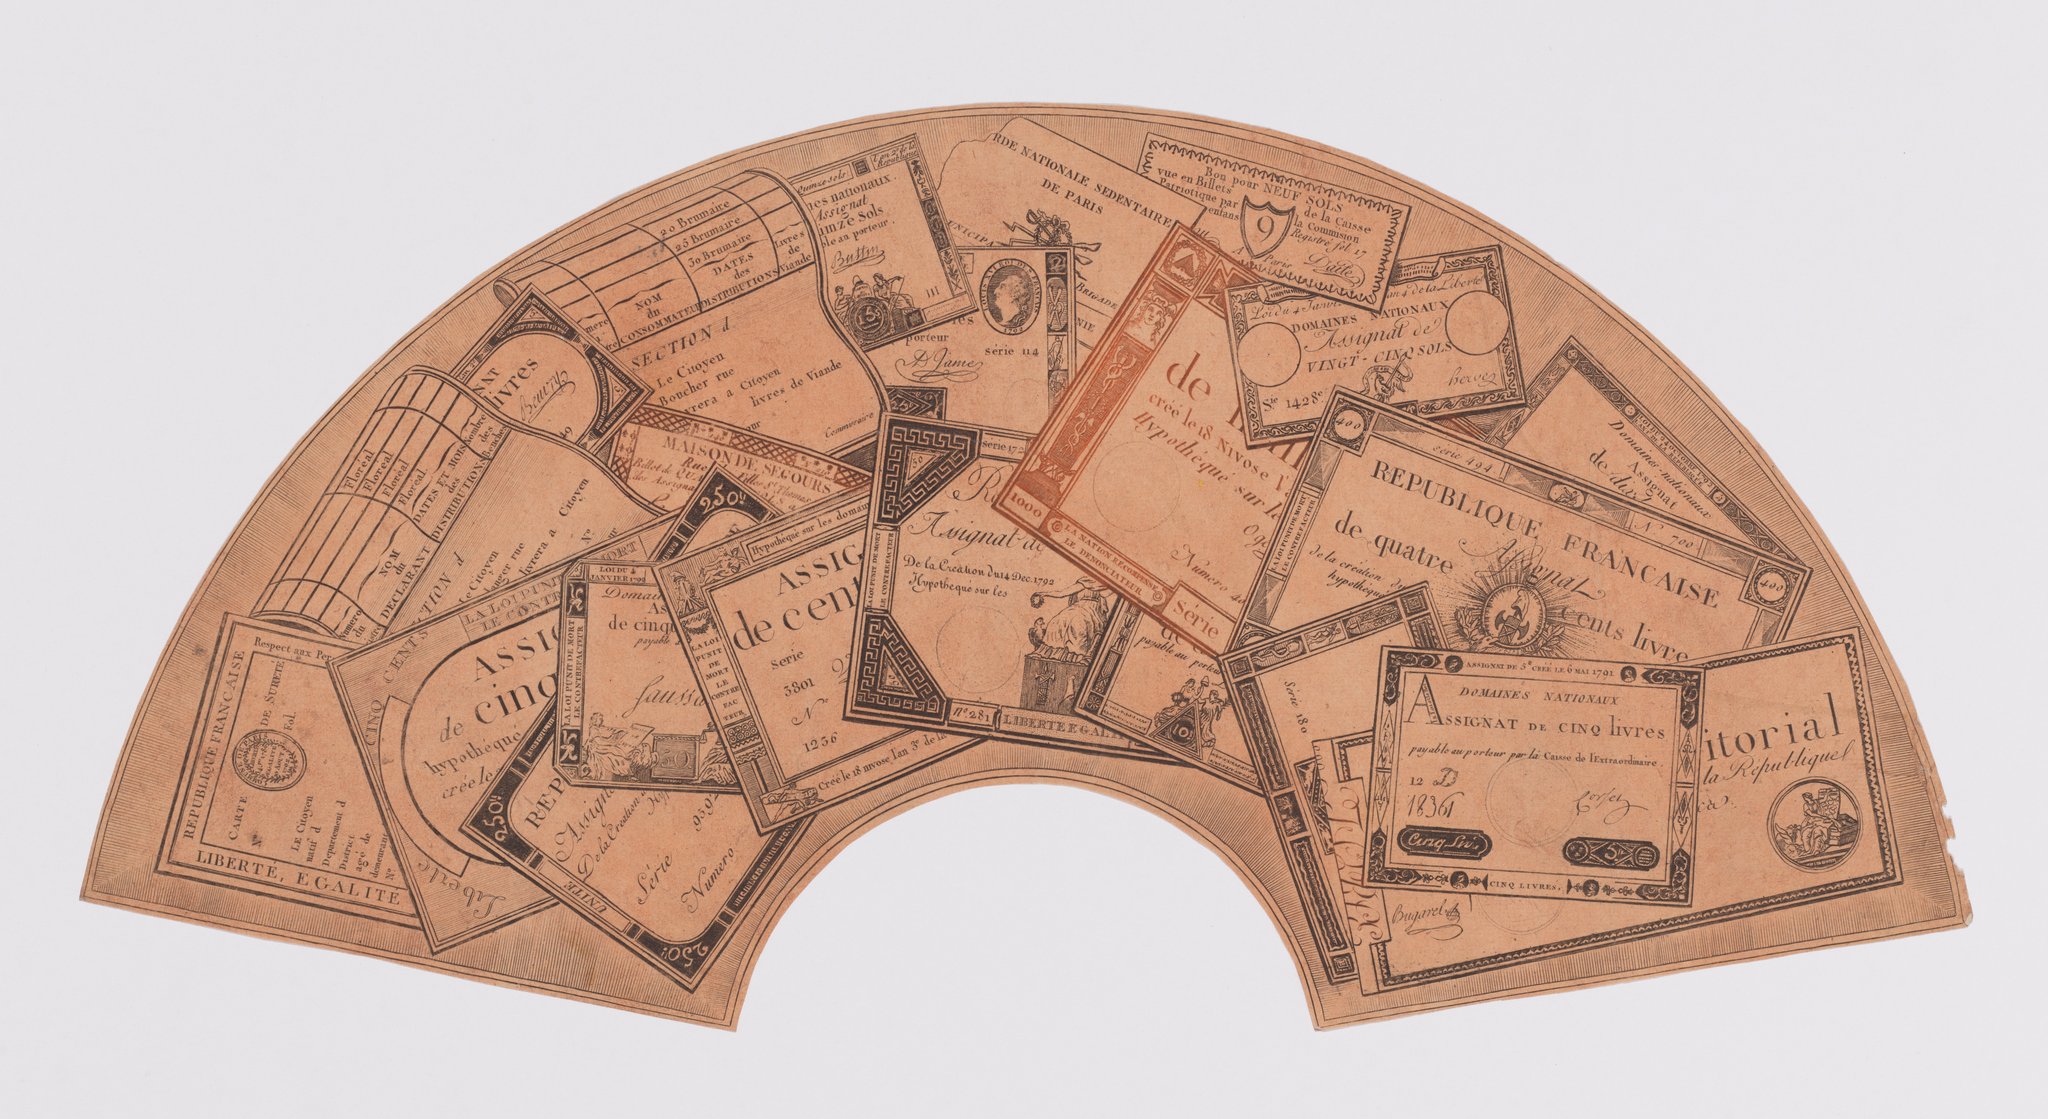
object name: print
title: Fan leaf with assignats from the First French Republic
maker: anonymous, french, 18th century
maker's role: artist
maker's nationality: french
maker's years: 1700-1800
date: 1794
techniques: engraving, etching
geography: france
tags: money